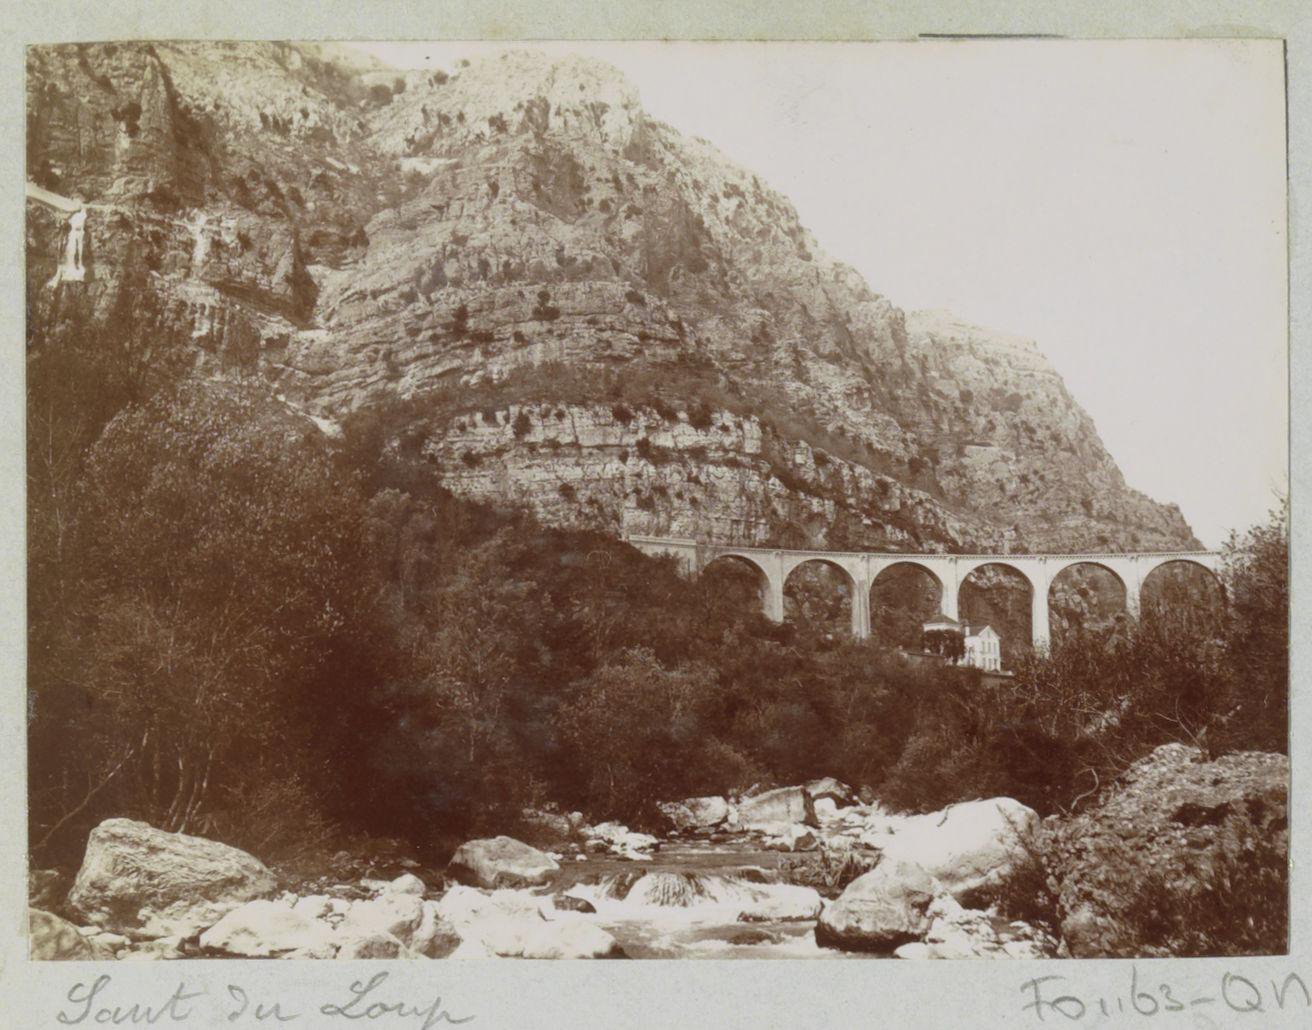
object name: photograph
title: Viaduct bij Pont du Loup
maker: delizy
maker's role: manufacturer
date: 1903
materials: paper, photographic support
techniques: gelatin silver print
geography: pont du loup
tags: prospect of village, silhouette of village, landscape with bridge, viaduct or aqueduct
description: Onderdeel van Fotoalbum van een Franse amateurfotograaf met opnames van uitstapjes in Frankrijk, Spanje, België, Luxemburg en Nederland, de eerste automobielen en autoraces.